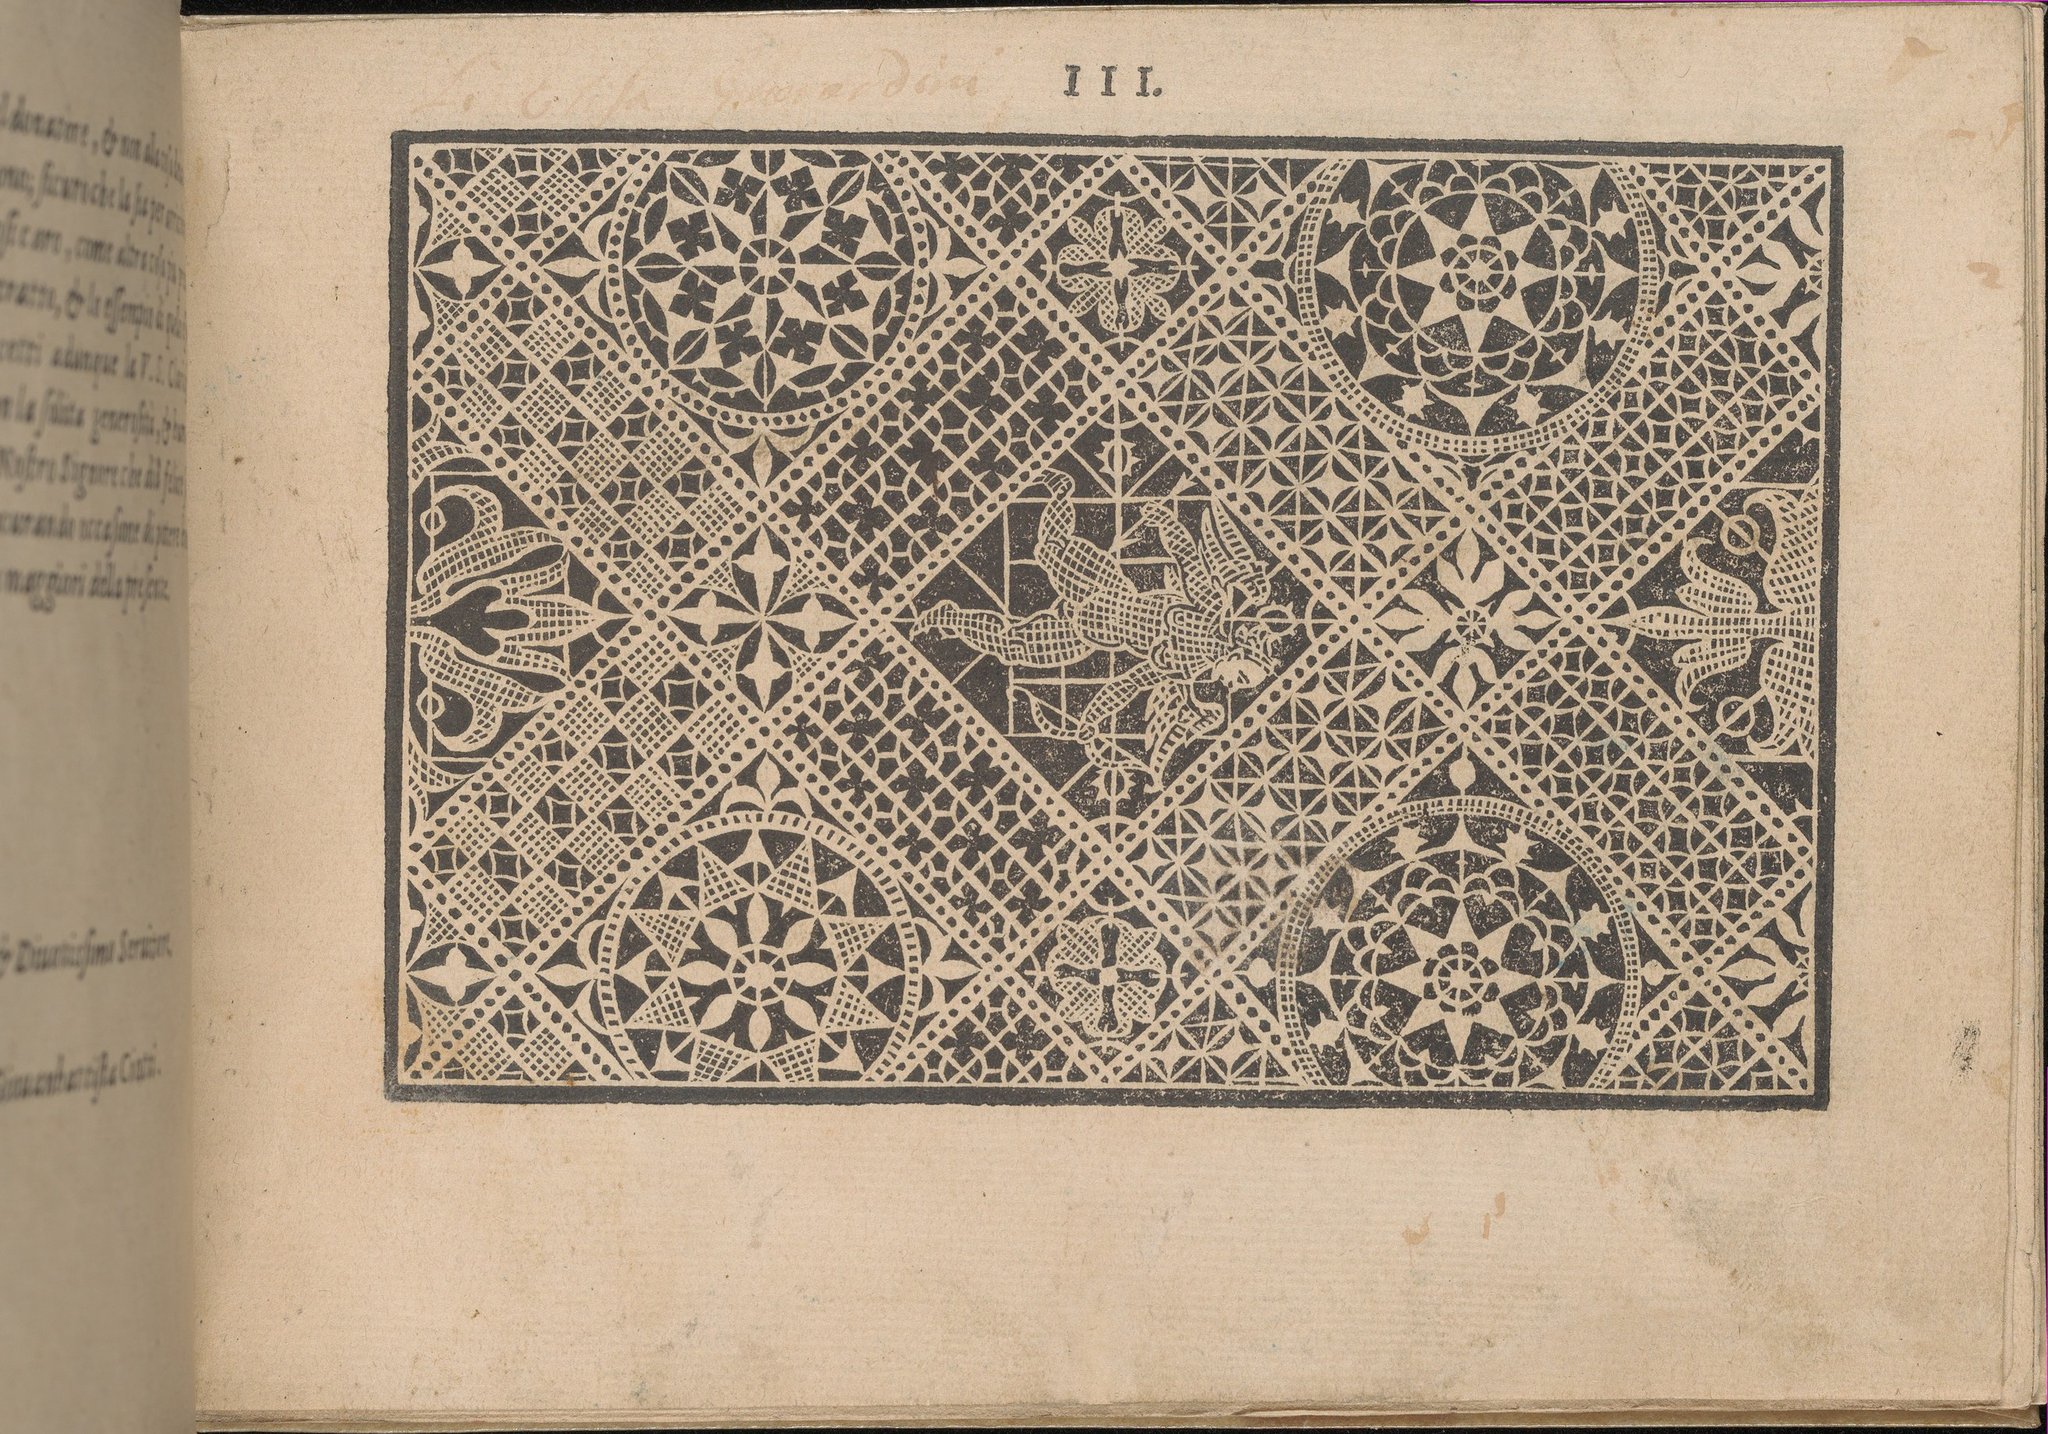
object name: book print ornament architecture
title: Prima Parte de' Fiori, e Disegni di varie sorti di Ricami Moderni, page 3 (recto)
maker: giovanni battista ciotti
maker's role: author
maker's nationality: italian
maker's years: 1555-1659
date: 1591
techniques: woodcut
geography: italy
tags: flowers